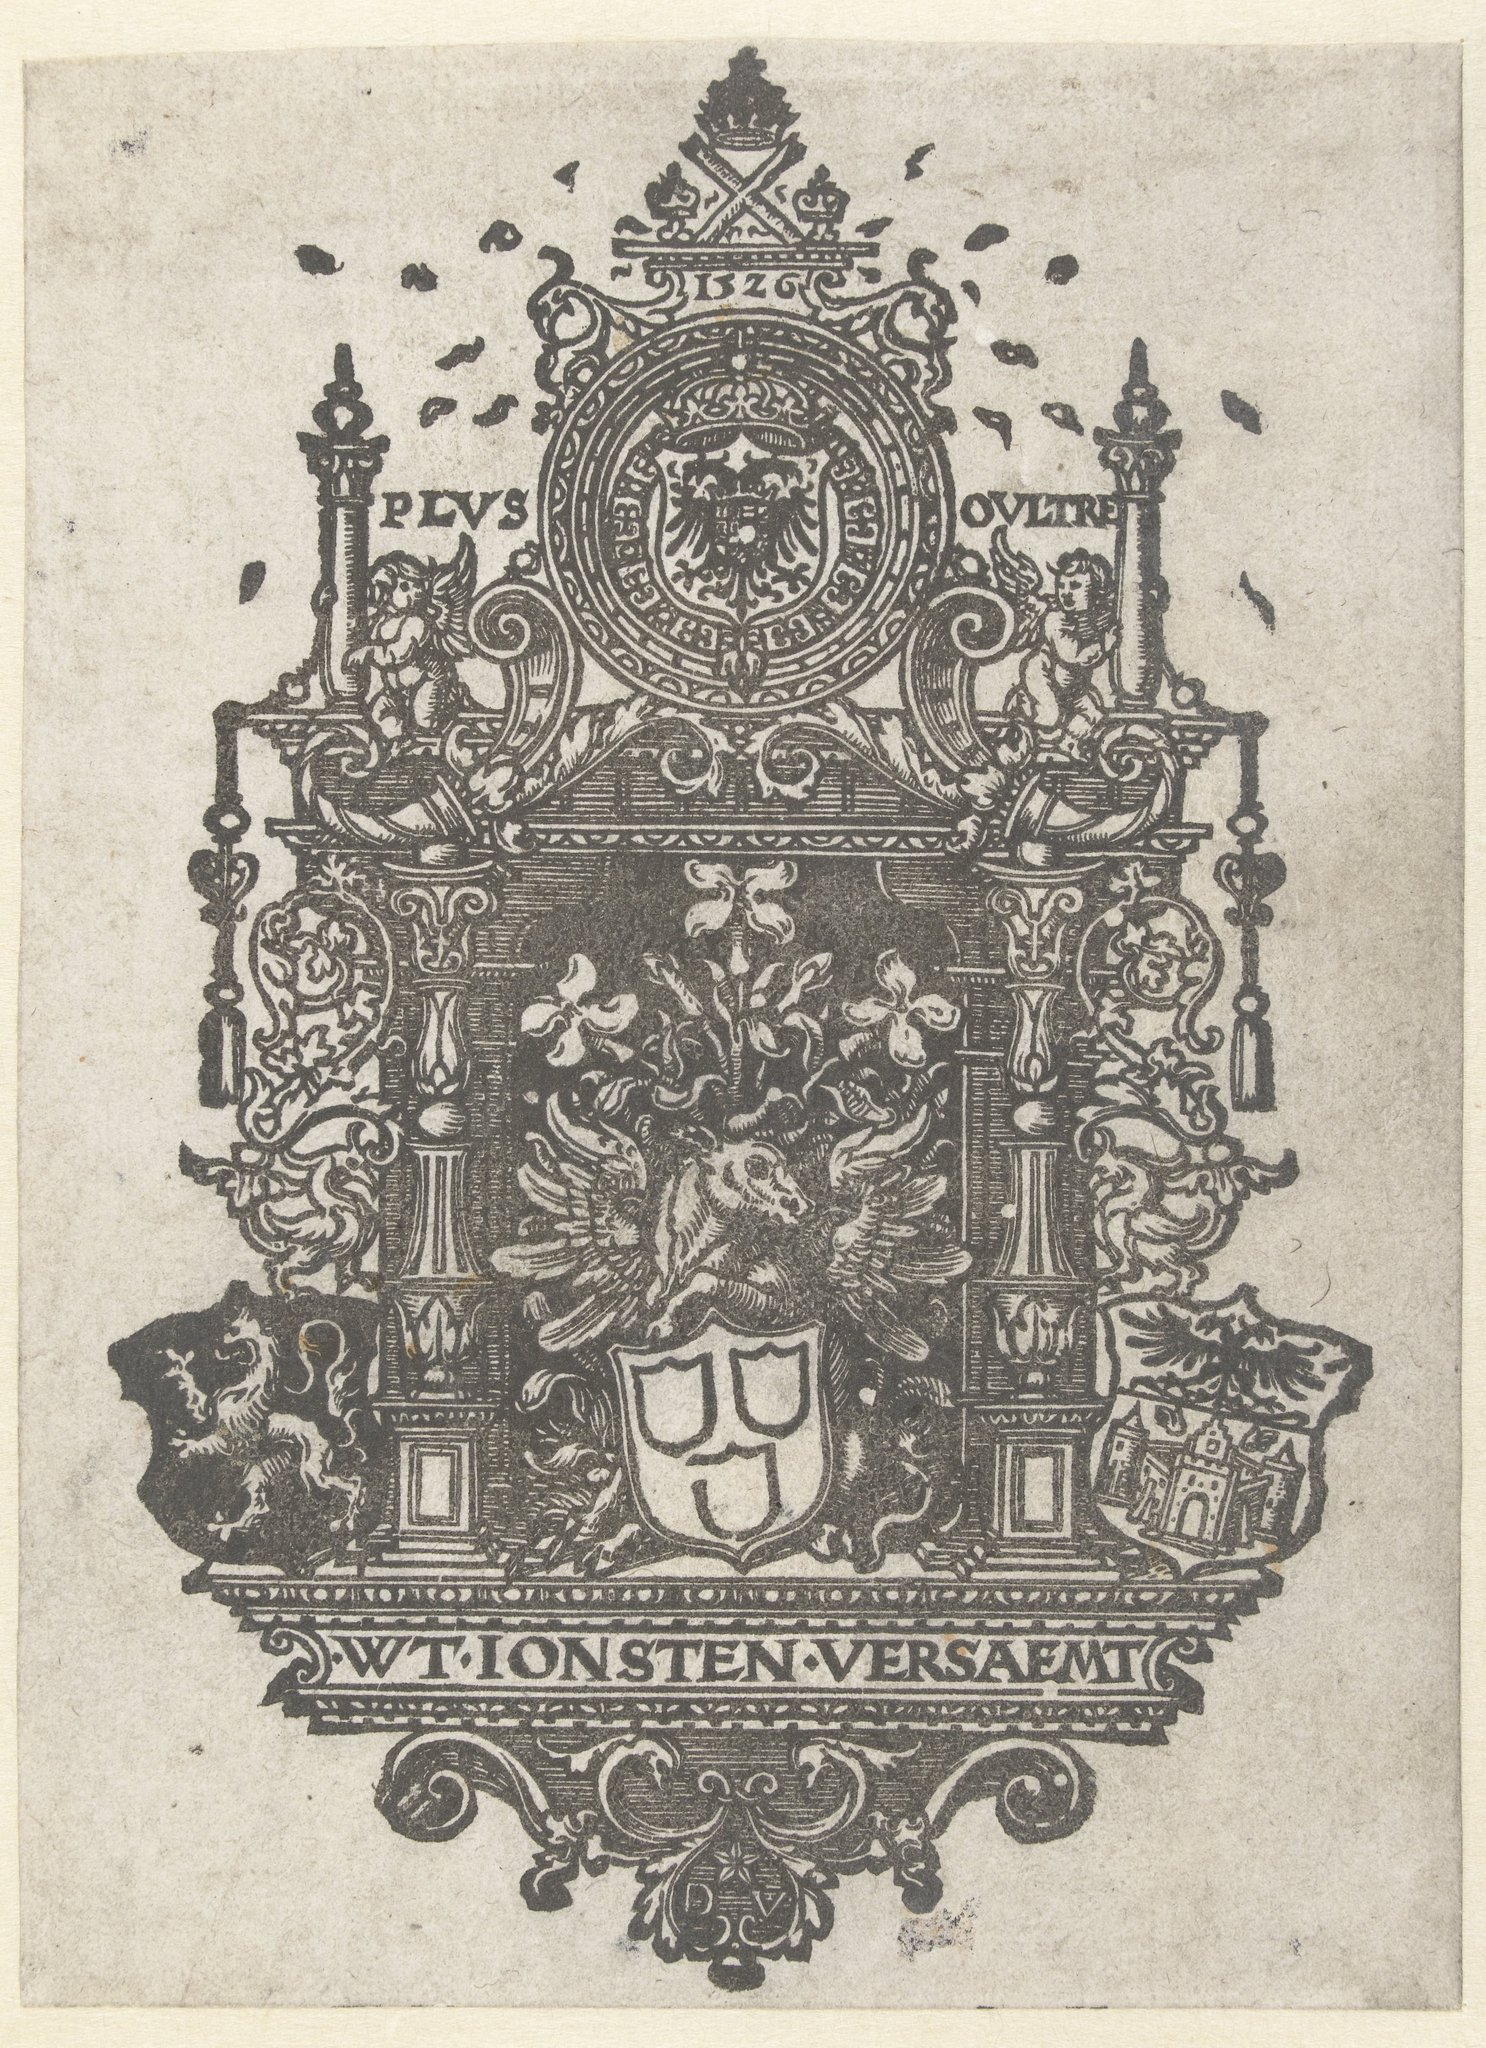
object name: print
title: Blazoen van het St Lucasgild te Antwerpen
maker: dirck vellert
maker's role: draughtsman, painter, print maker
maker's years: 1480-1547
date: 1526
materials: paper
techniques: woodcut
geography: low countries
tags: coat of arms of guild of st. luke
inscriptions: date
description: Blazoen met wapens van de stad Antwerpen en gevleugelde os in het midden.